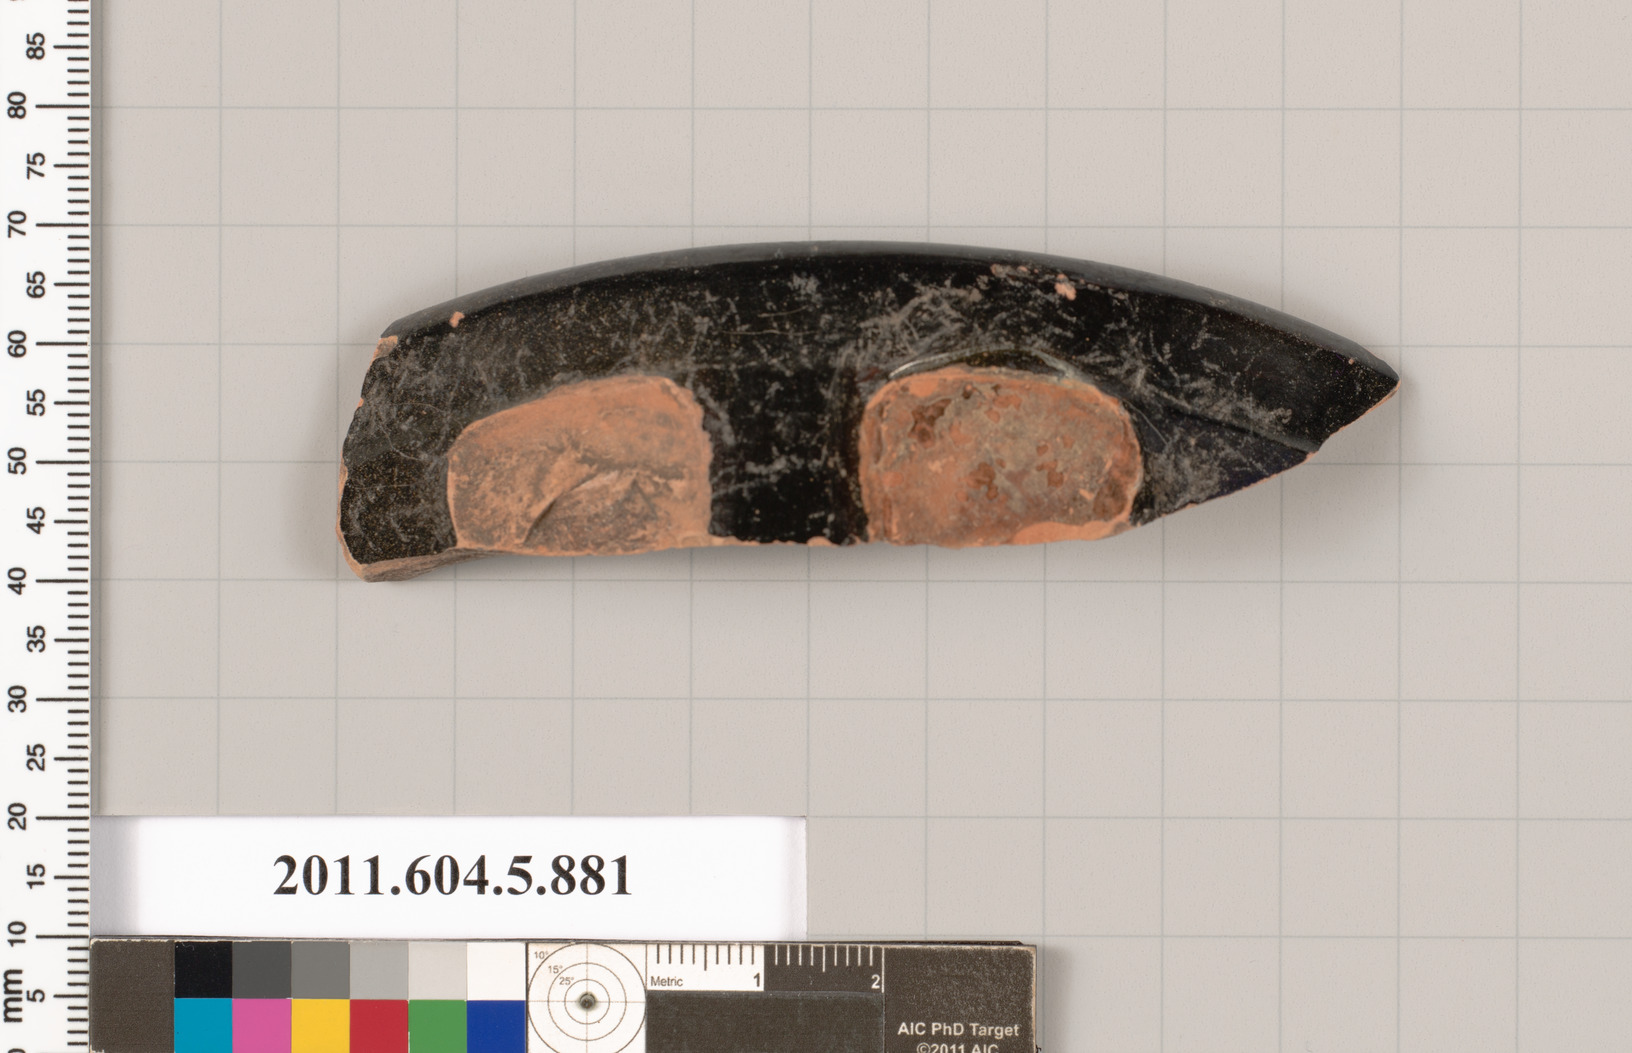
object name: kylix fragment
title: Terracotta rim fragment of a kylix (drinking cup)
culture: greek, attic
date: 600-401 BCE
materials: terracotta